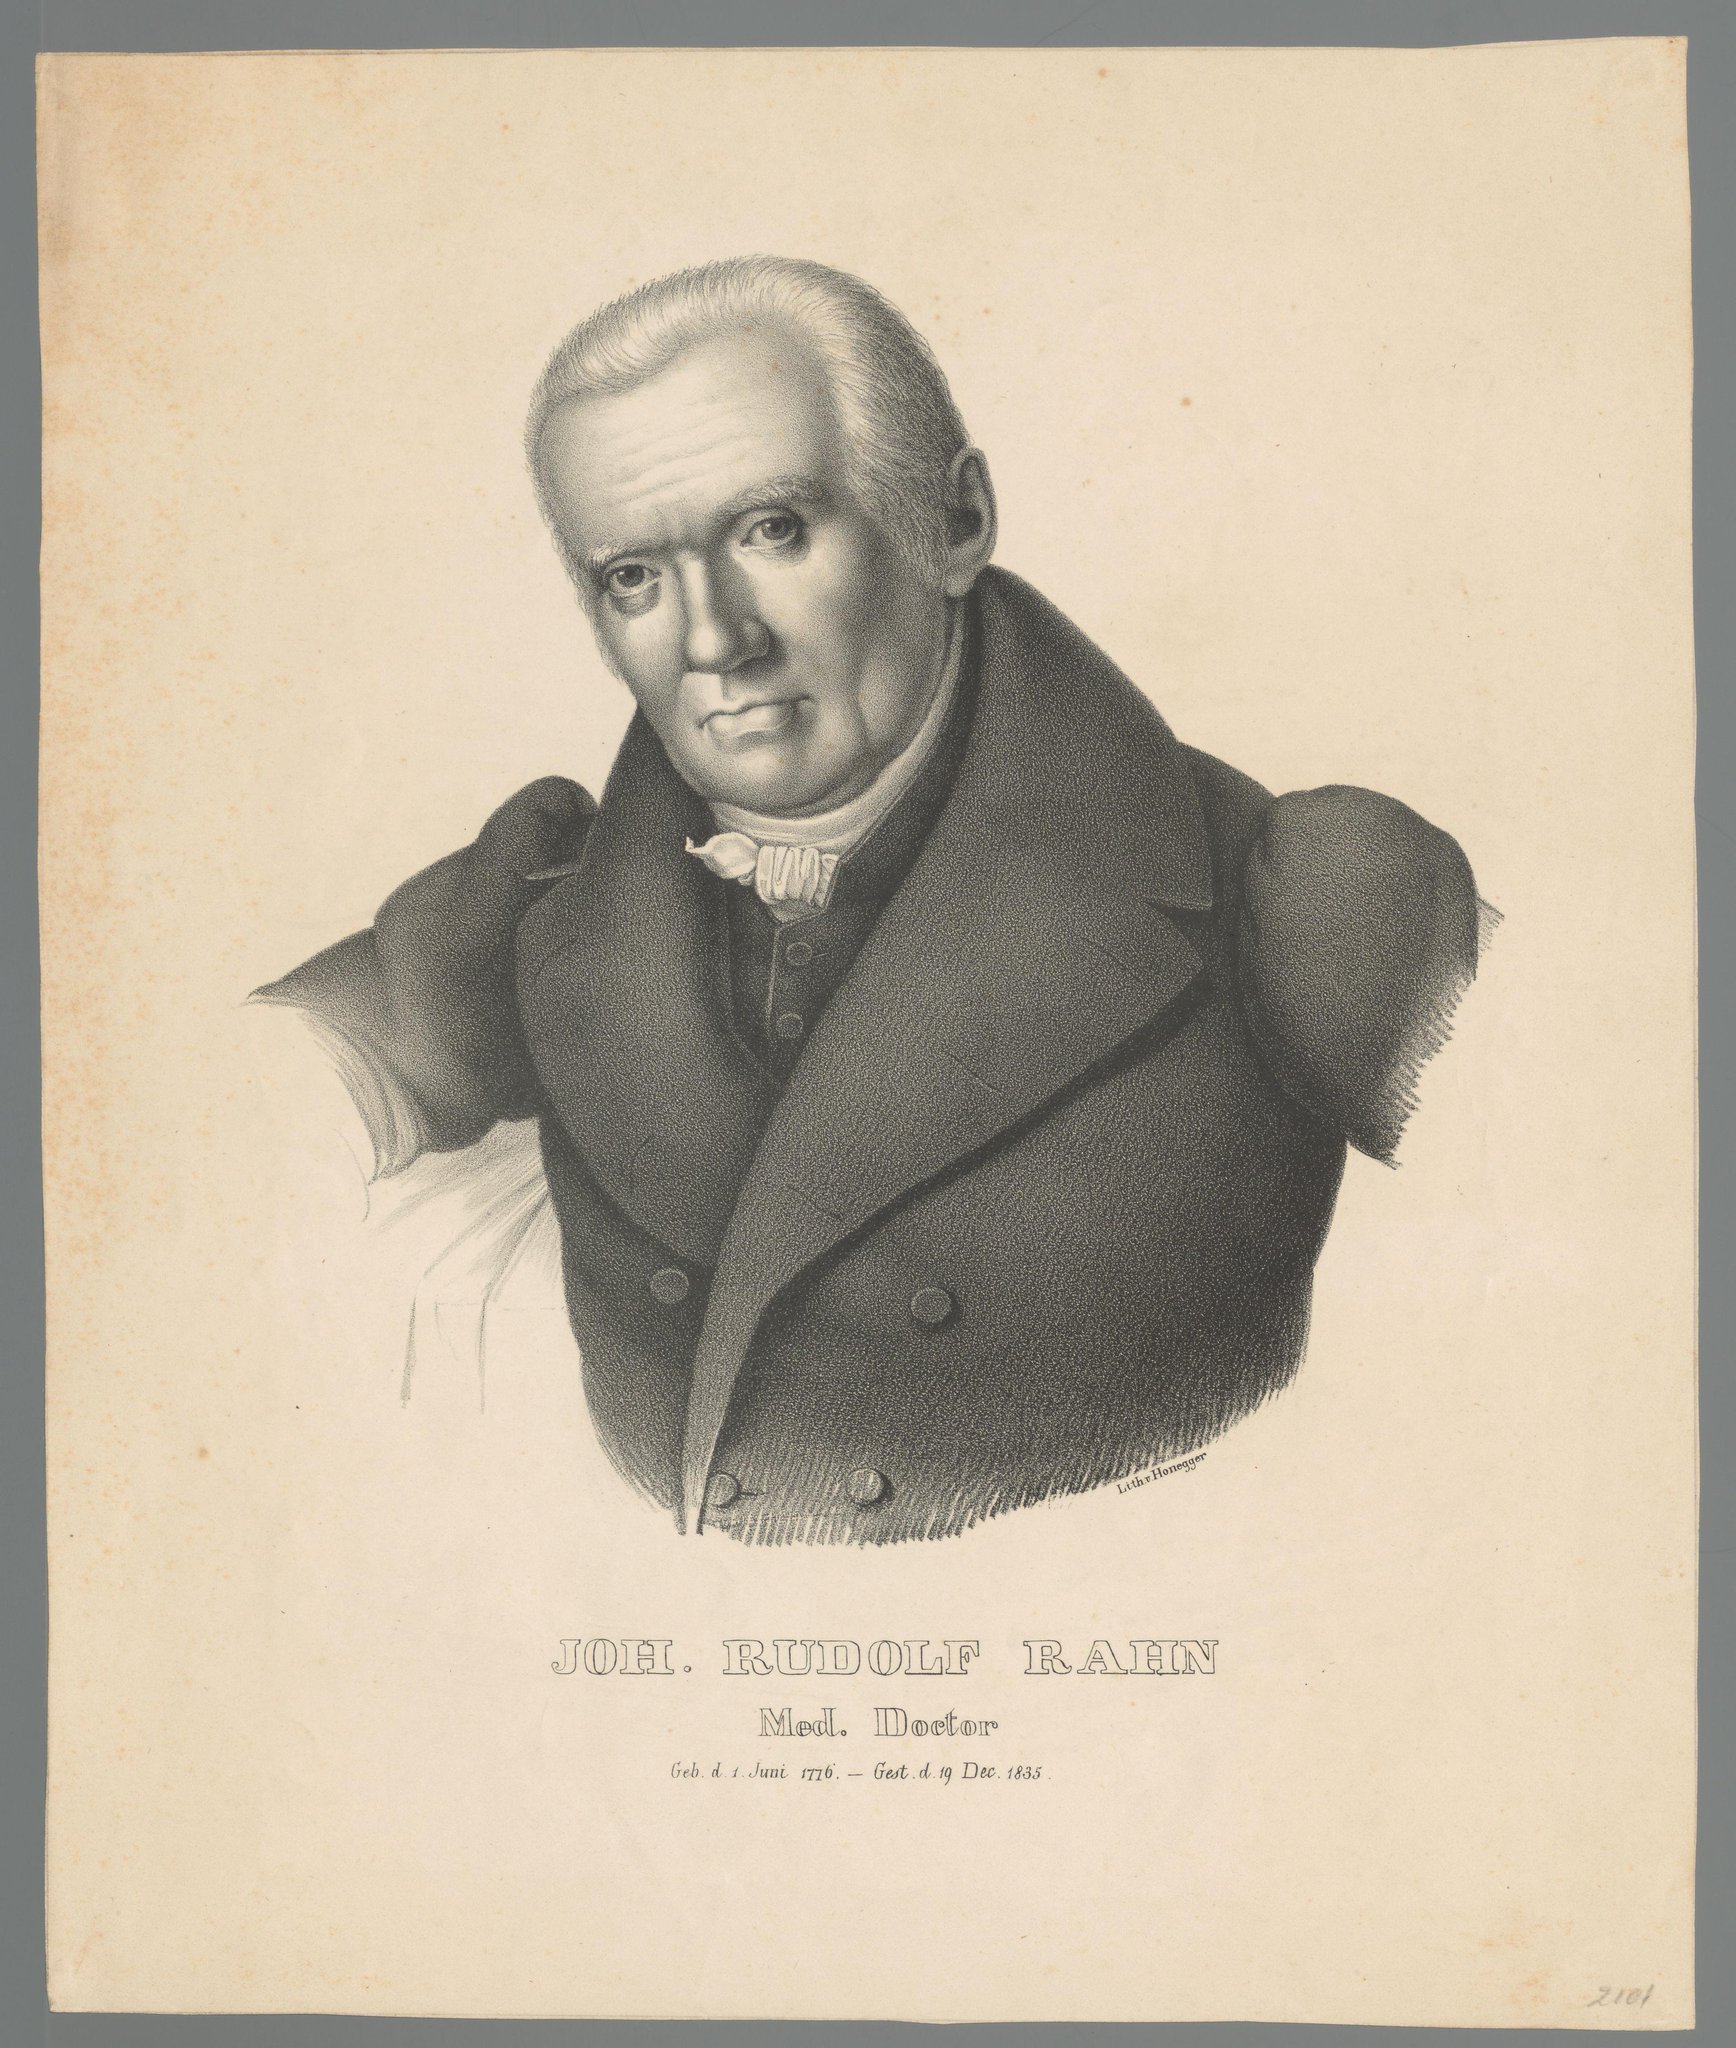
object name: print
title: Portret van Johann Rudolf Rahn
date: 1835-1845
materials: paper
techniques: lithograph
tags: adult man, historical persons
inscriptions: collector's mark: Lugt 2228